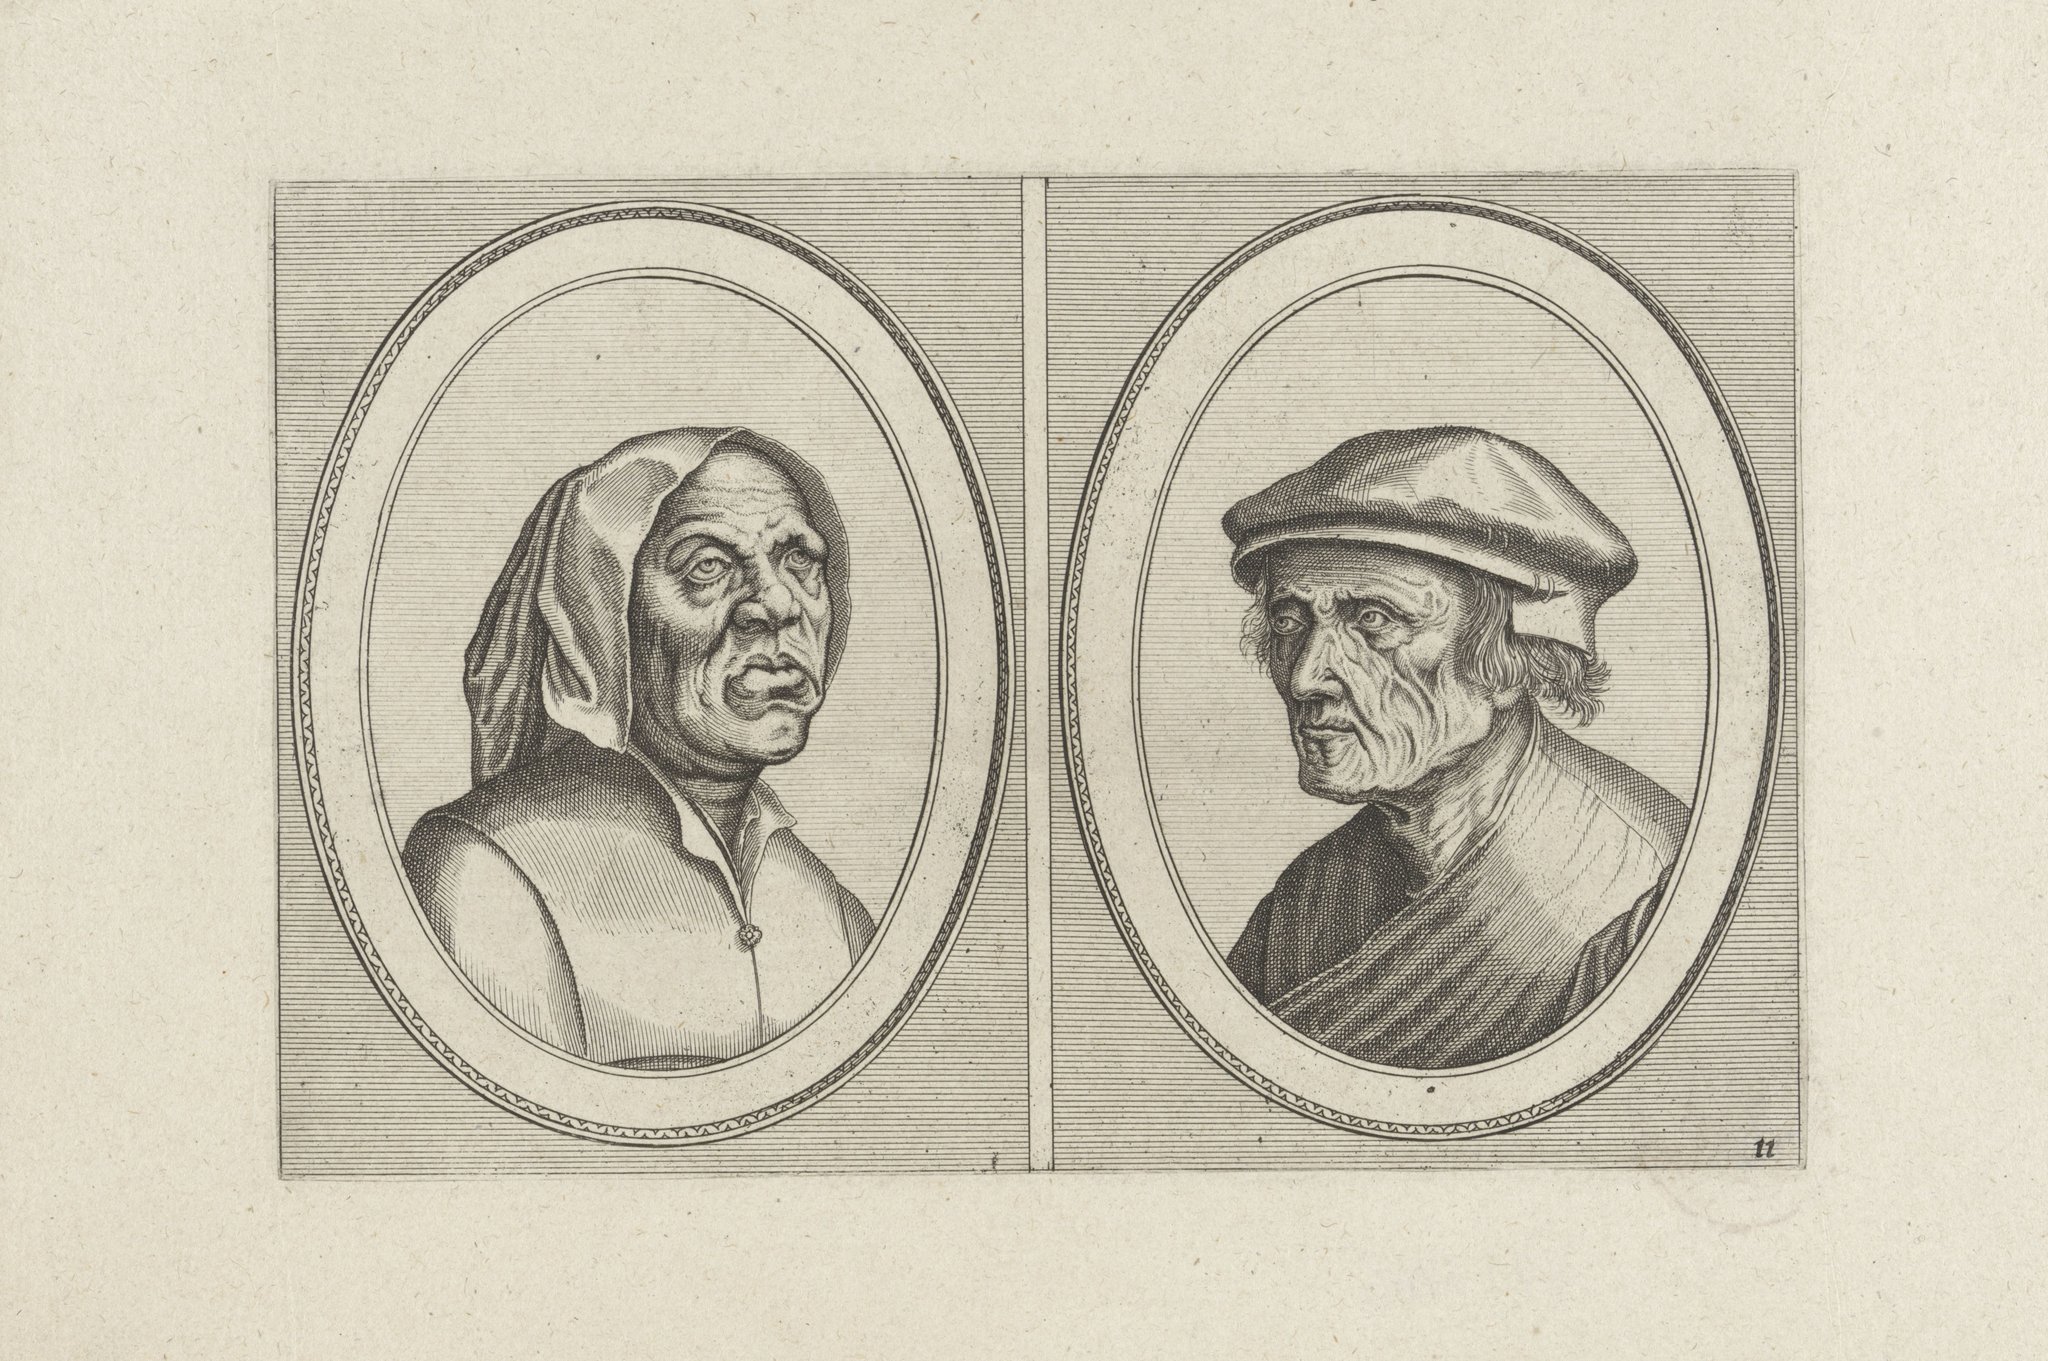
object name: print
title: Baef Schol-bex en Spruyt Vroegh-bedorven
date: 1612-1652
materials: paper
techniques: engraving, etching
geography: amsterdam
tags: head-gear, farmers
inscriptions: collector's mark: Lugt 700, collector's mark: Lugt 240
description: Prent uit een serie van 36 prenten met koppen van boeren en boerinnen.